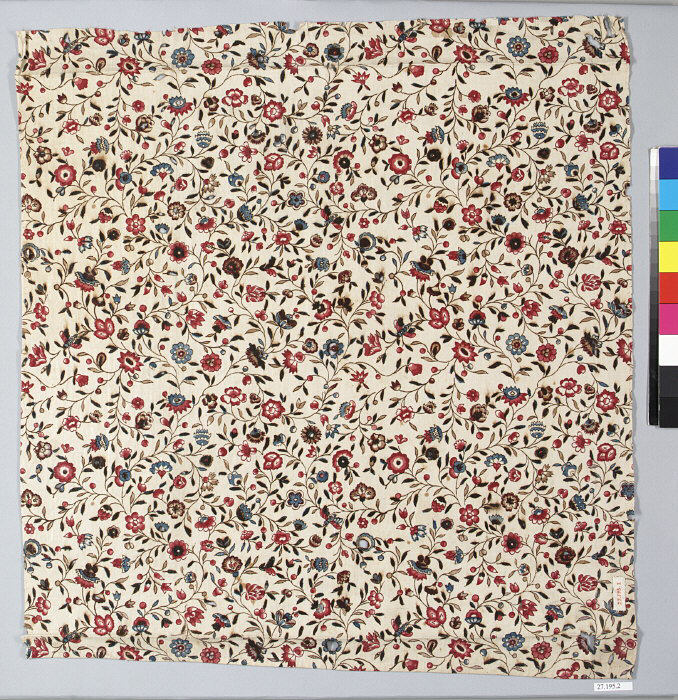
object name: fragment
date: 1800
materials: cotton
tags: flowers,leaves